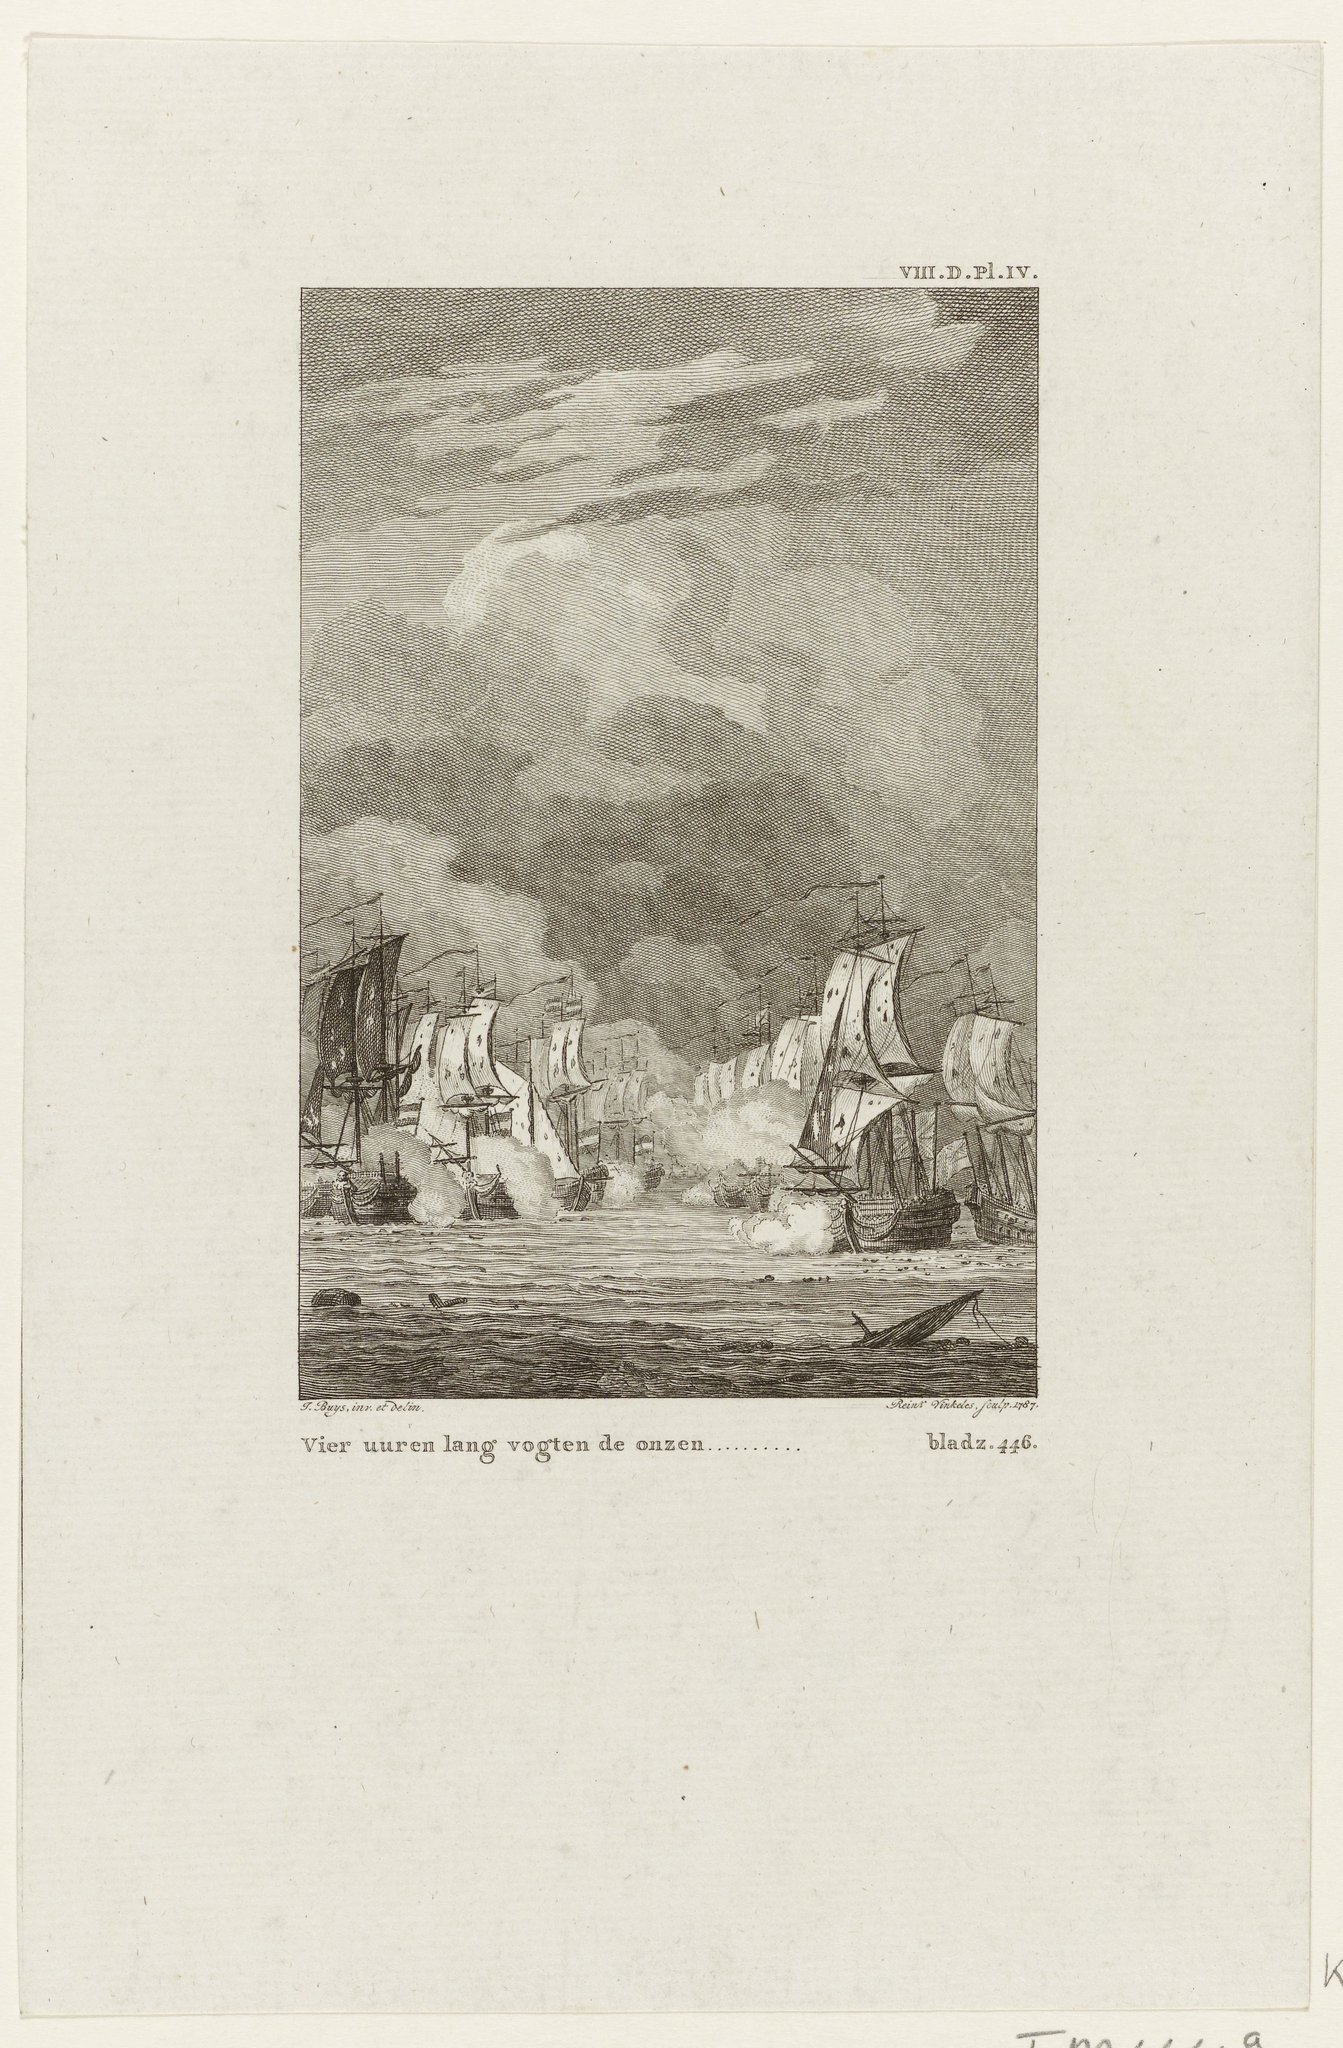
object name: print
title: Zeeslag bij Doggersbank, 1781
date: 1787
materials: paper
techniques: engraving, etching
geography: northern netherlands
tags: the hague, johan arnold zoutman, hyde parker, battle (+ naval force)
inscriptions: collector's mark: Lugt 240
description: De Nederlandse en Engelse schepen tijdens de zeeslag bij Doggersbank op 5 augustus 1781 tussen de Nederlandse vloot onder schout-bij-nacht Johan Zoutman en de Engelse vloot onder vice-admiraal Hyde Parker. Onderaan een citaat "Vier uuren lang vogten de onzen ..." en de vermelding van bladz. 446. Rechtsboven gemerkt: VIII.D.Pl.IV.